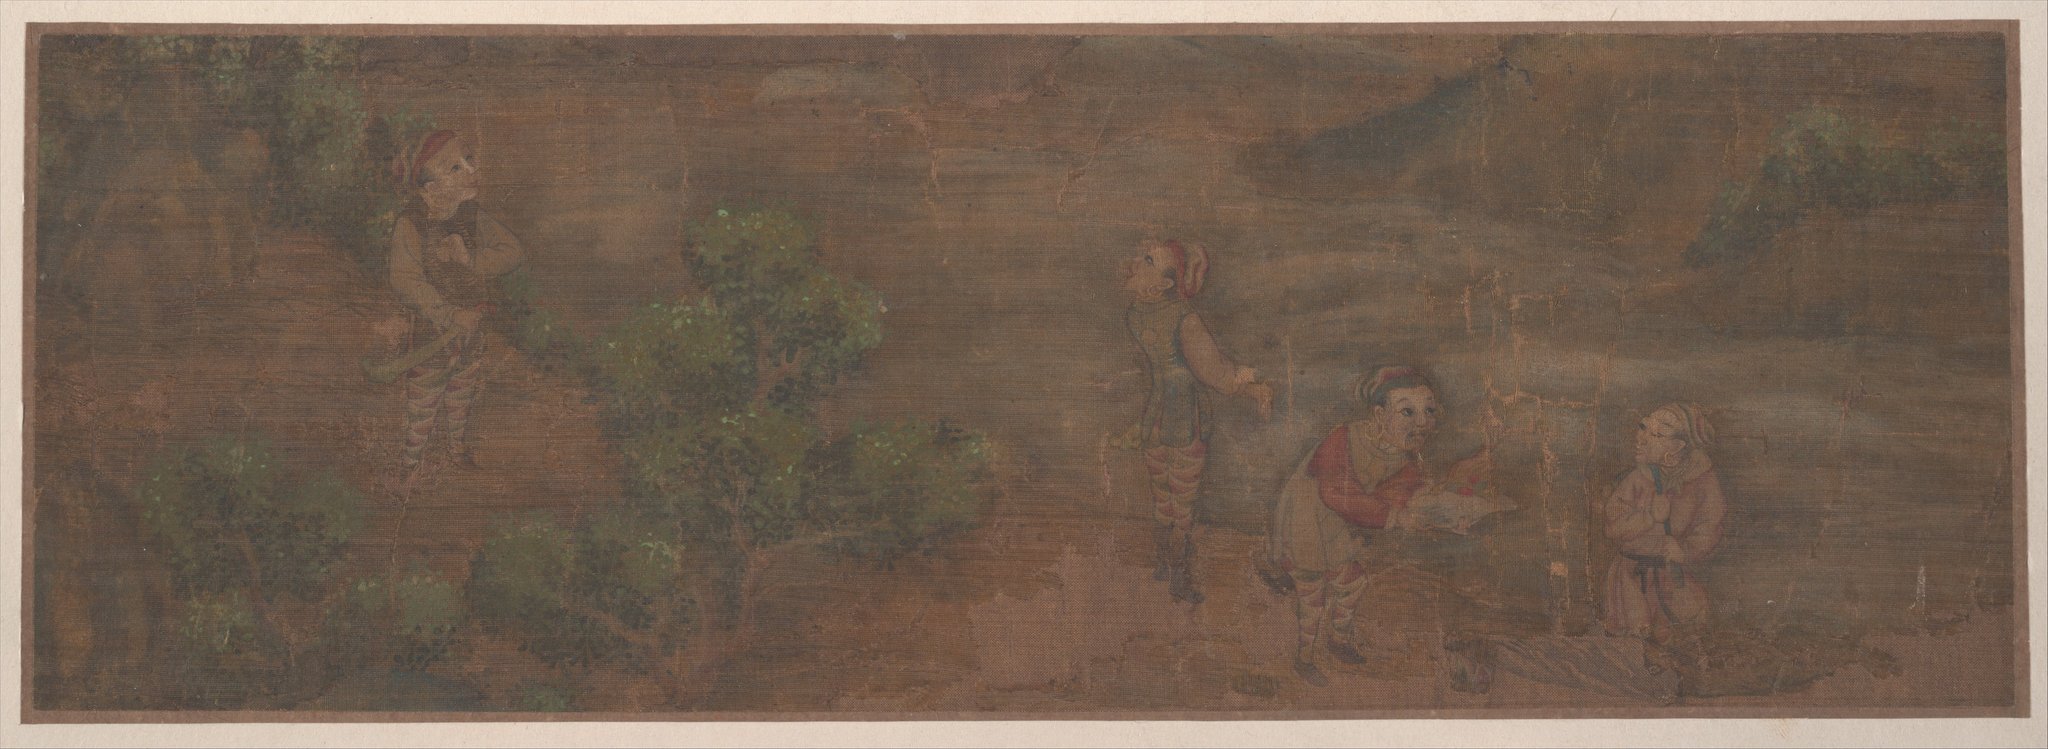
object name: album leaf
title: Landscape Painting of Figure in Woodland Setting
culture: chinese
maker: unidentified artist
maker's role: artist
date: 1644-1911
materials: silk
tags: men,landscapes